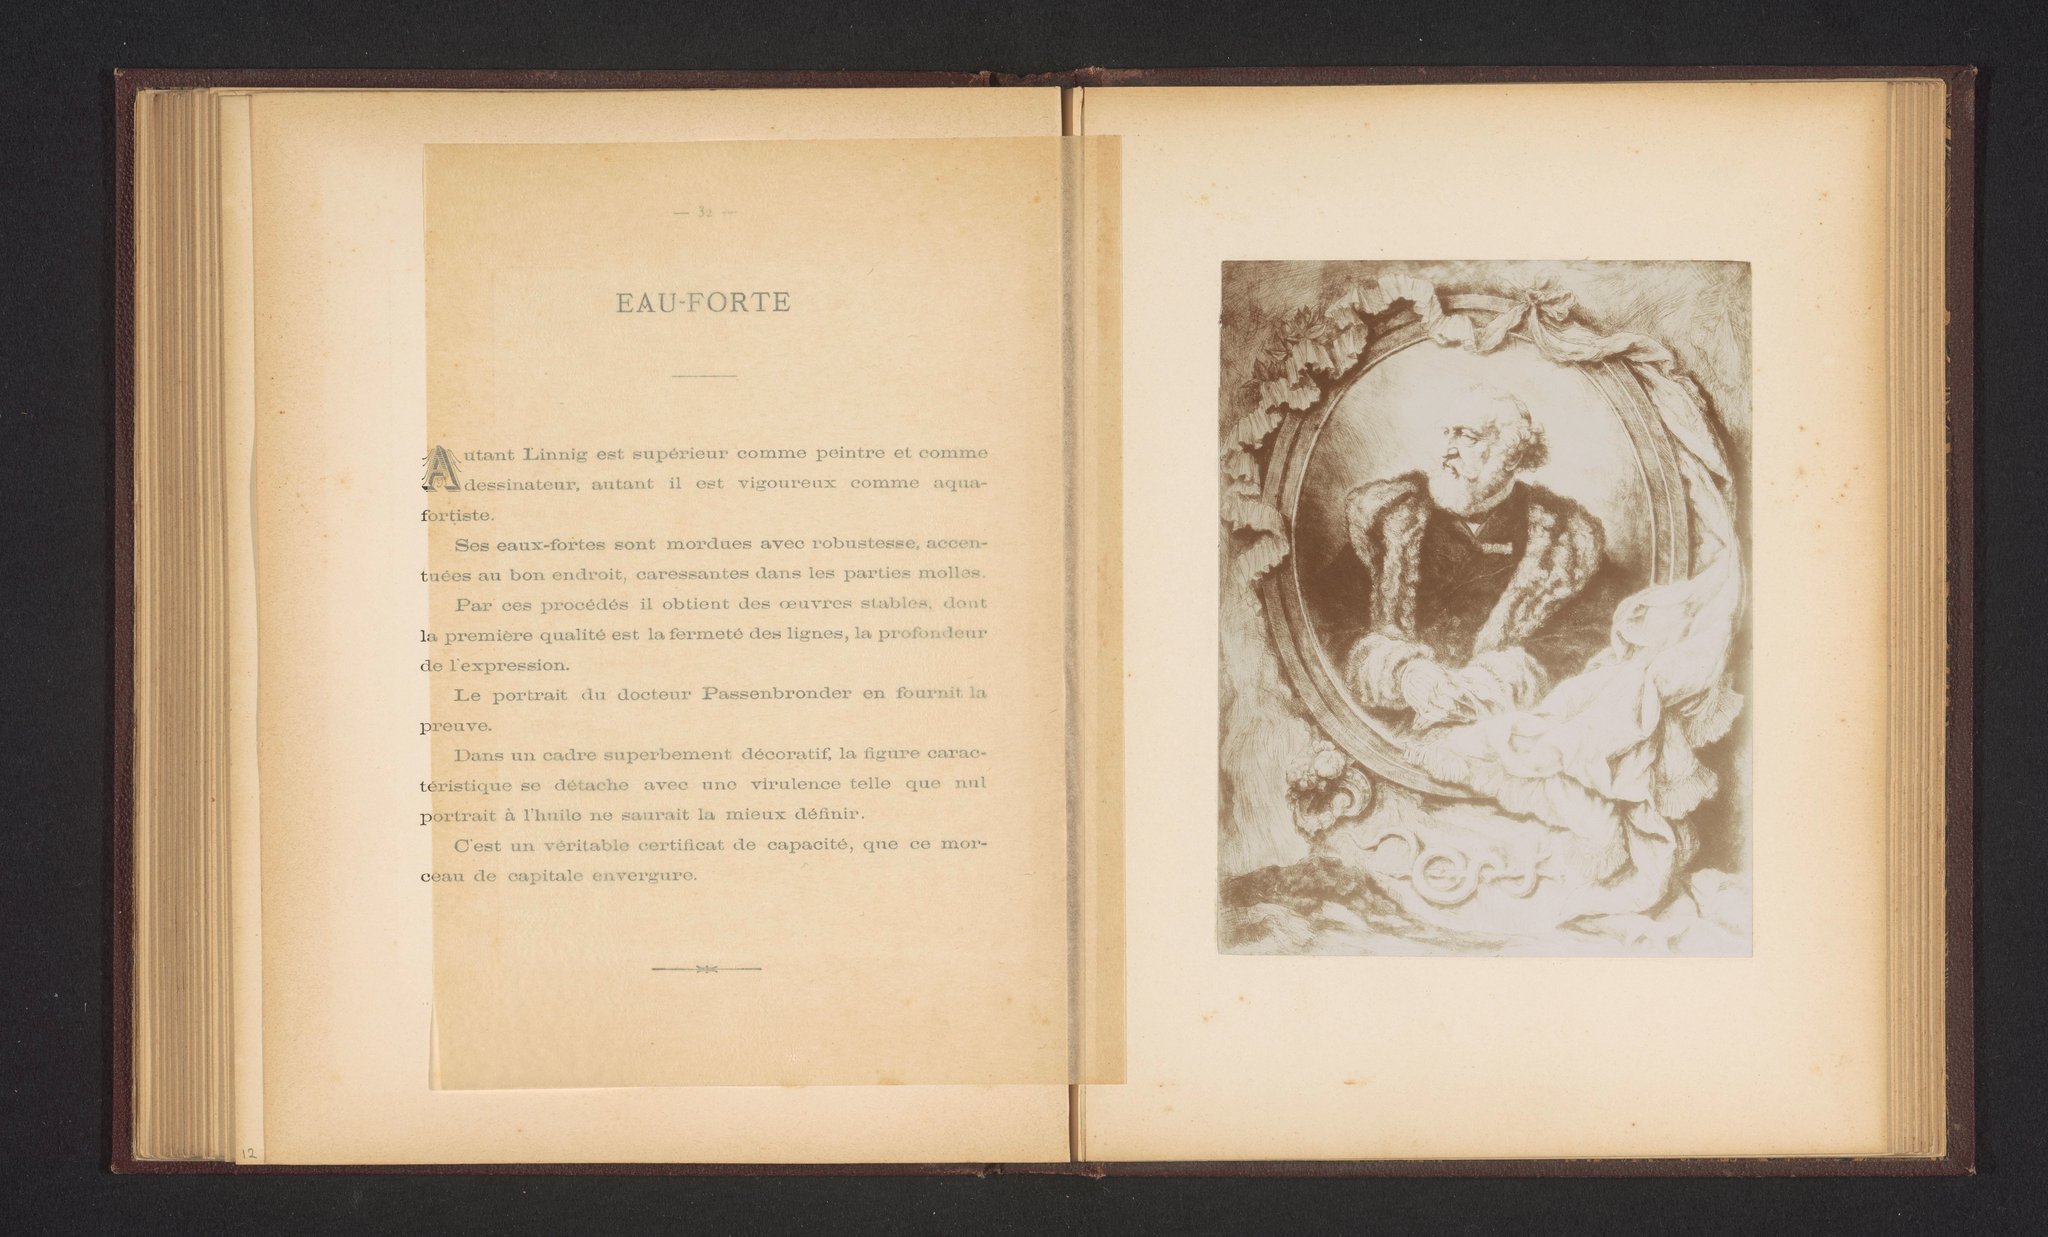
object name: reproduction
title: Fotoreproductie van een ets van een portret van Albert Passenbronder door Willem Linnig (II)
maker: alexandre van antro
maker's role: painter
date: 1891-1896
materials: photographic support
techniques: collodion silver print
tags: historical persons